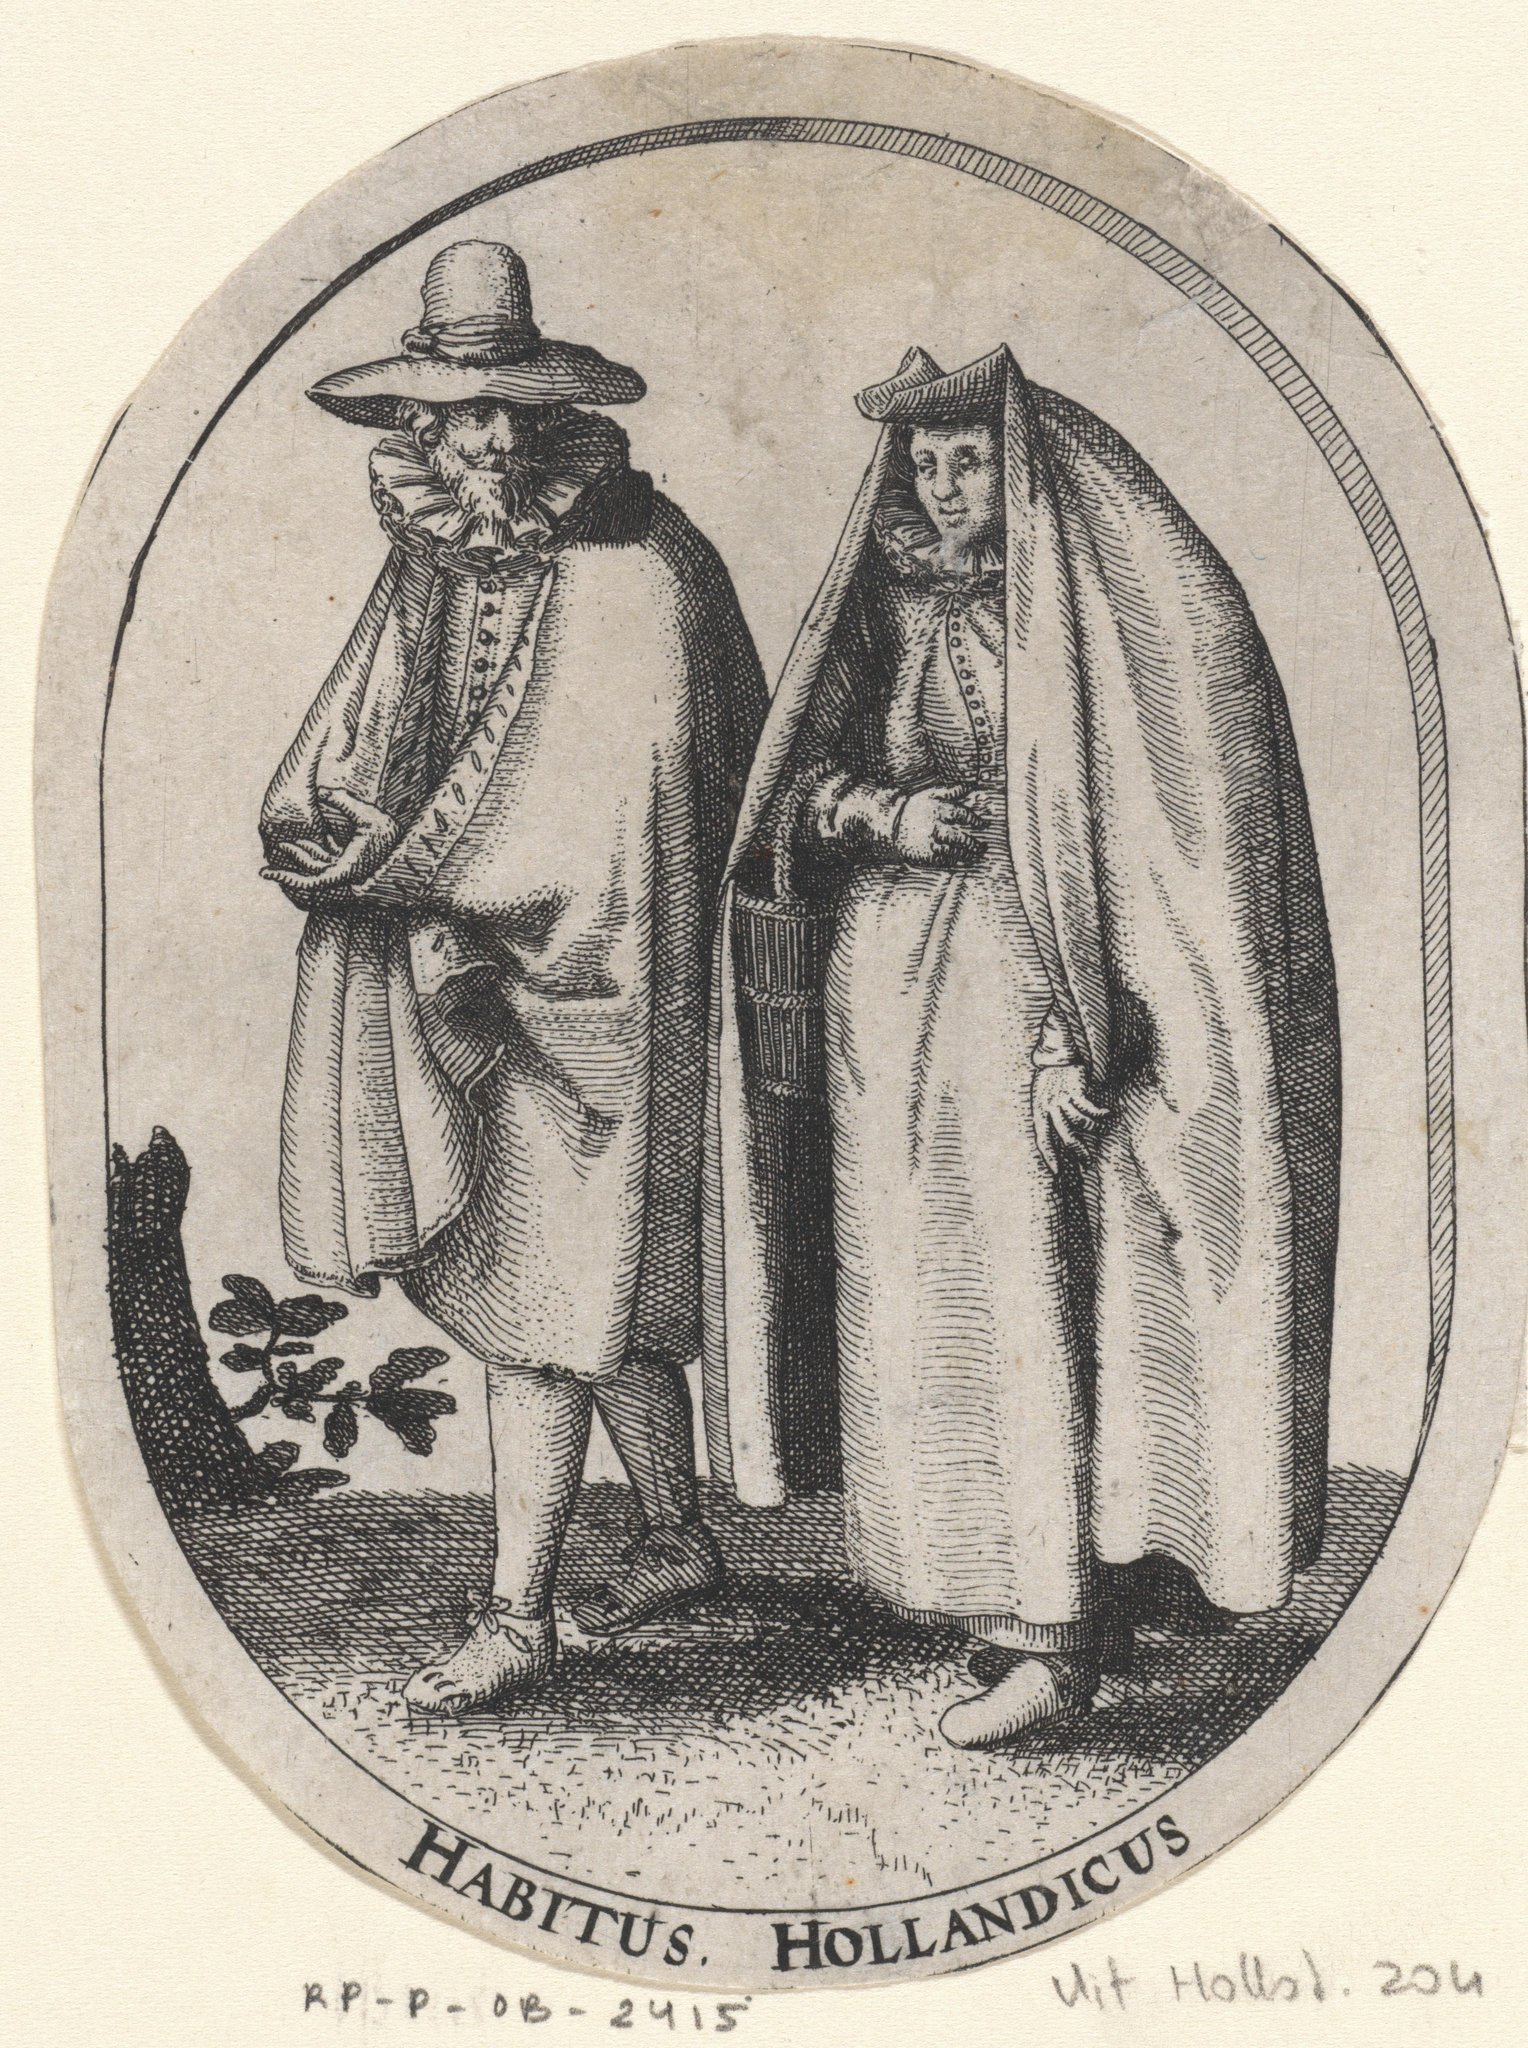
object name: costume print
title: Habitus Hollandicus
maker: claes jansz. visscher (ii)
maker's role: draughtsman, print maker, publisher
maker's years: 1586-1652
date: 1618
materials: paper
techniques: etching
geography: amsterdam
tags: neck-gear ~ clothing (with name) (+ men's clothes), cape (+ men's clothes), cape (huik) (+ women's clothes), head-gear: hat (+ men's clothes), neck-gear ~ clothing (with name) (+ women's clothes), shoes, sandals (+ men's clothes), clothes, costume (+ men's clothes), europeans (with name)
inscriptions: collector's mark: Lugt 2228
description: Deze prent is afkomstig uit de rand van de wereldkaart die in 1607 werd uitgegeven door Herman Allartsz. Koster en David de Meyne, Hollstein nr. 204.